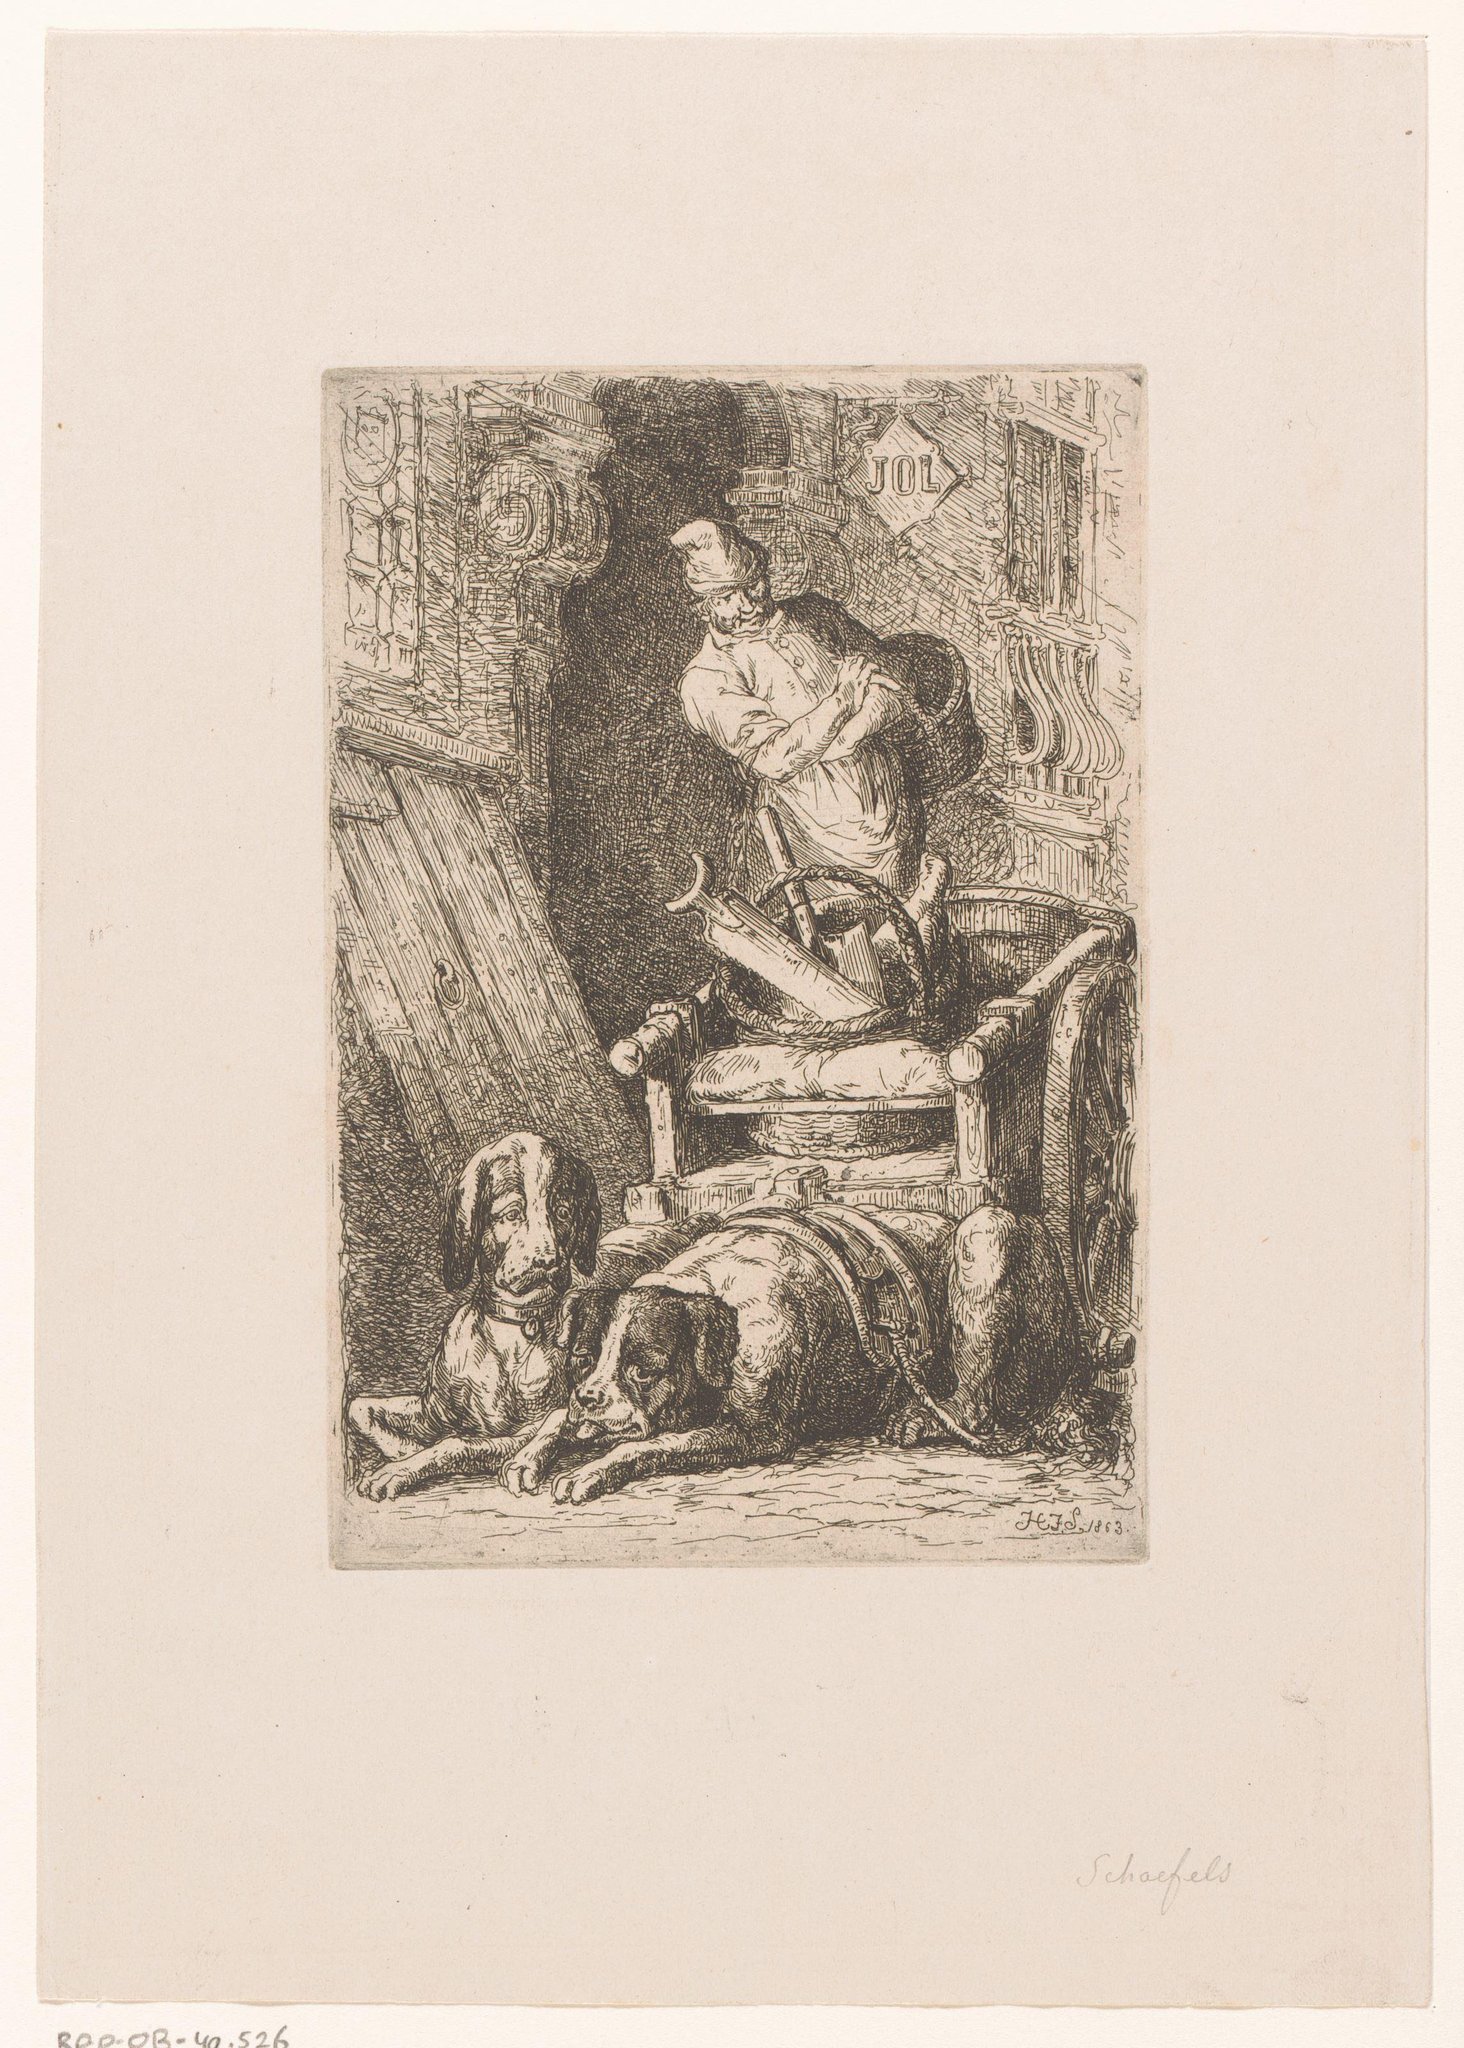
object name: print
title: Slager bij een wagen getrokken door twee honden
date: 1863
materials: paper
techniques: etching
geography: antwerp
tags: butcher, slaughterman, two-wheeled vehicle drawn by two animals, dog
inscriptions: collector's mark: Lugt 2228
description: Op het uithangbord het pand op de achtergrond staat: Jol.